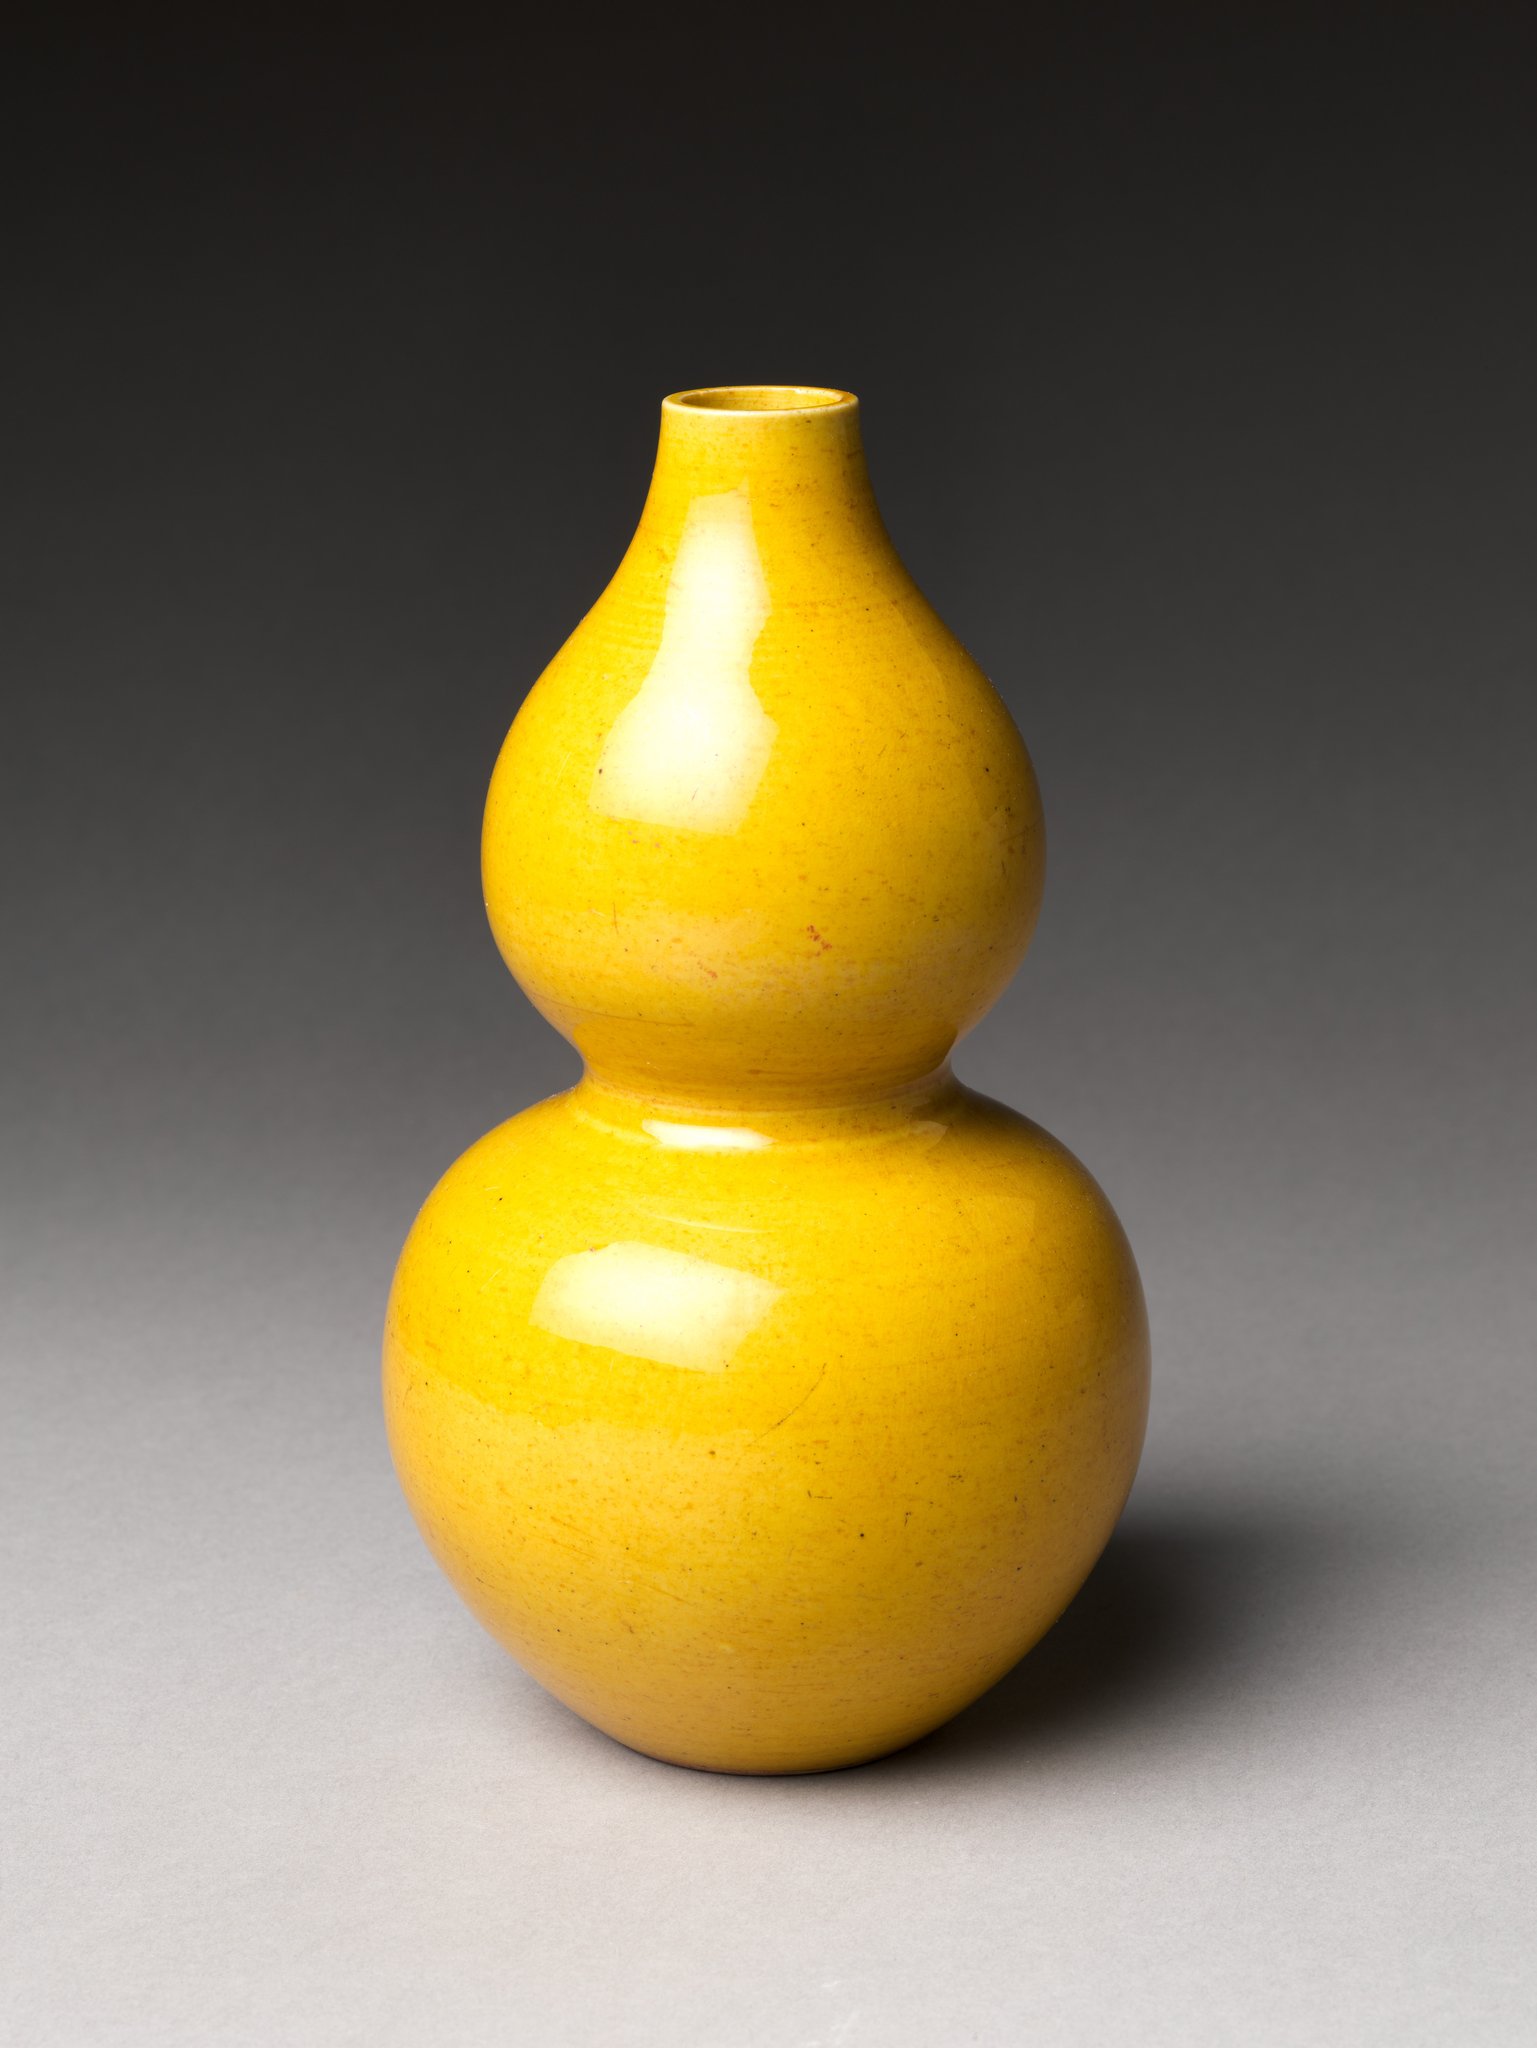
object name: vase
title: Vase in Shape of Double Gourd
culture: chinese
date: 1701-1733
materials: glaze, porcelain